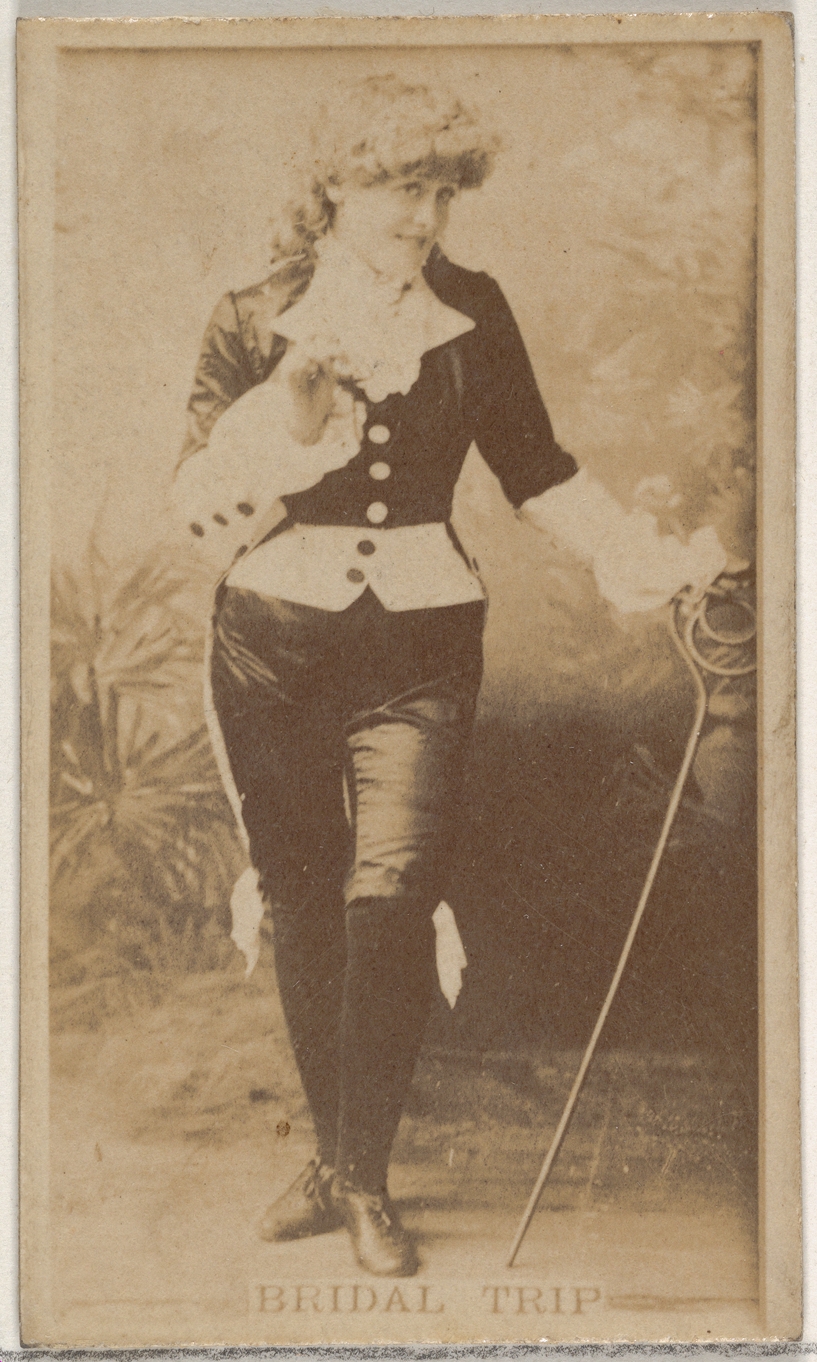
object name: photograph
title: Bridal Trip, from the Actors and Actresses series (N45, Type 8) for Virginia Brights Cigarettes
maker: allen & ginter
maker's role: publisher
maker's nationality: american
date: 1888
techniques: albumen silver print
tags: portraits,women,actresses